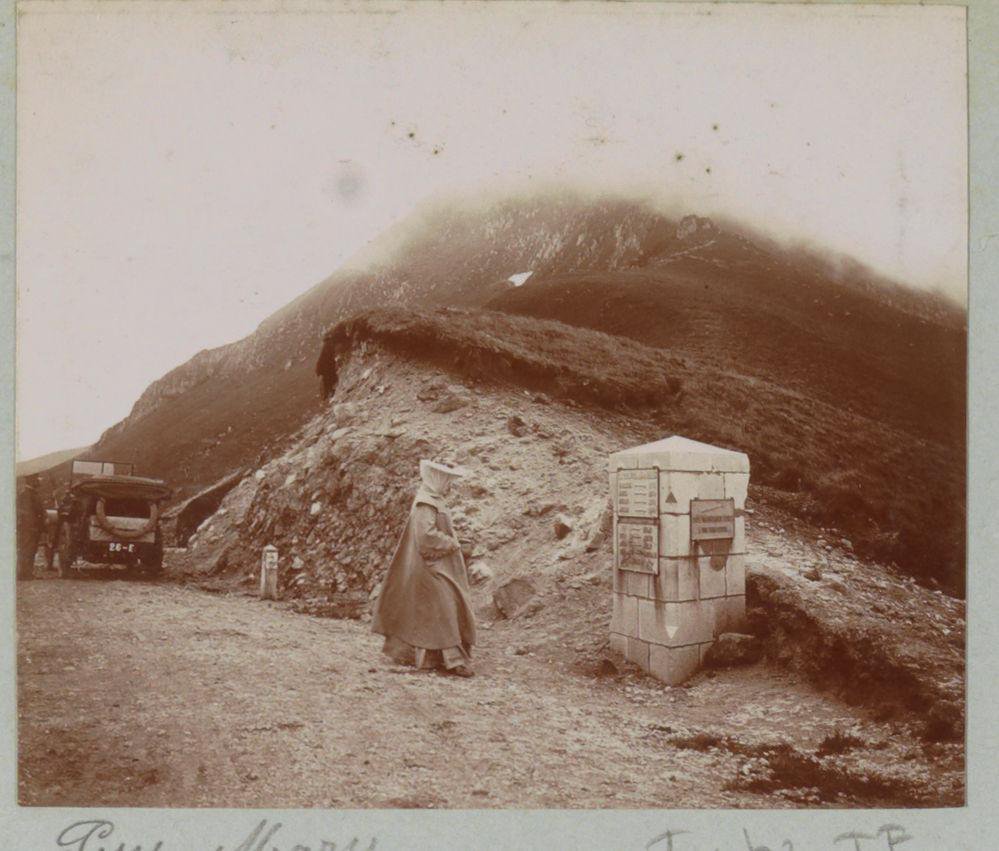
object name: photograph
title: Vrouw op de top van de Puy Marie, links een automobiel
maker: delizy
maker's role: manufacturer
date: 1903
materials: paper, photographic support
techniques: gelatin silver print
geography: auvergne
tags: mountain-top, peak (+ landscape with figures, staffage), road, path, mountains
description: Onderdeel van Fotoalbum van een Franse amateurfotograaf met opnames van uitstapjes in Frankrijk, Spanje, België, Luxemburg en Nederland, de eerste automobielen en autoraces.